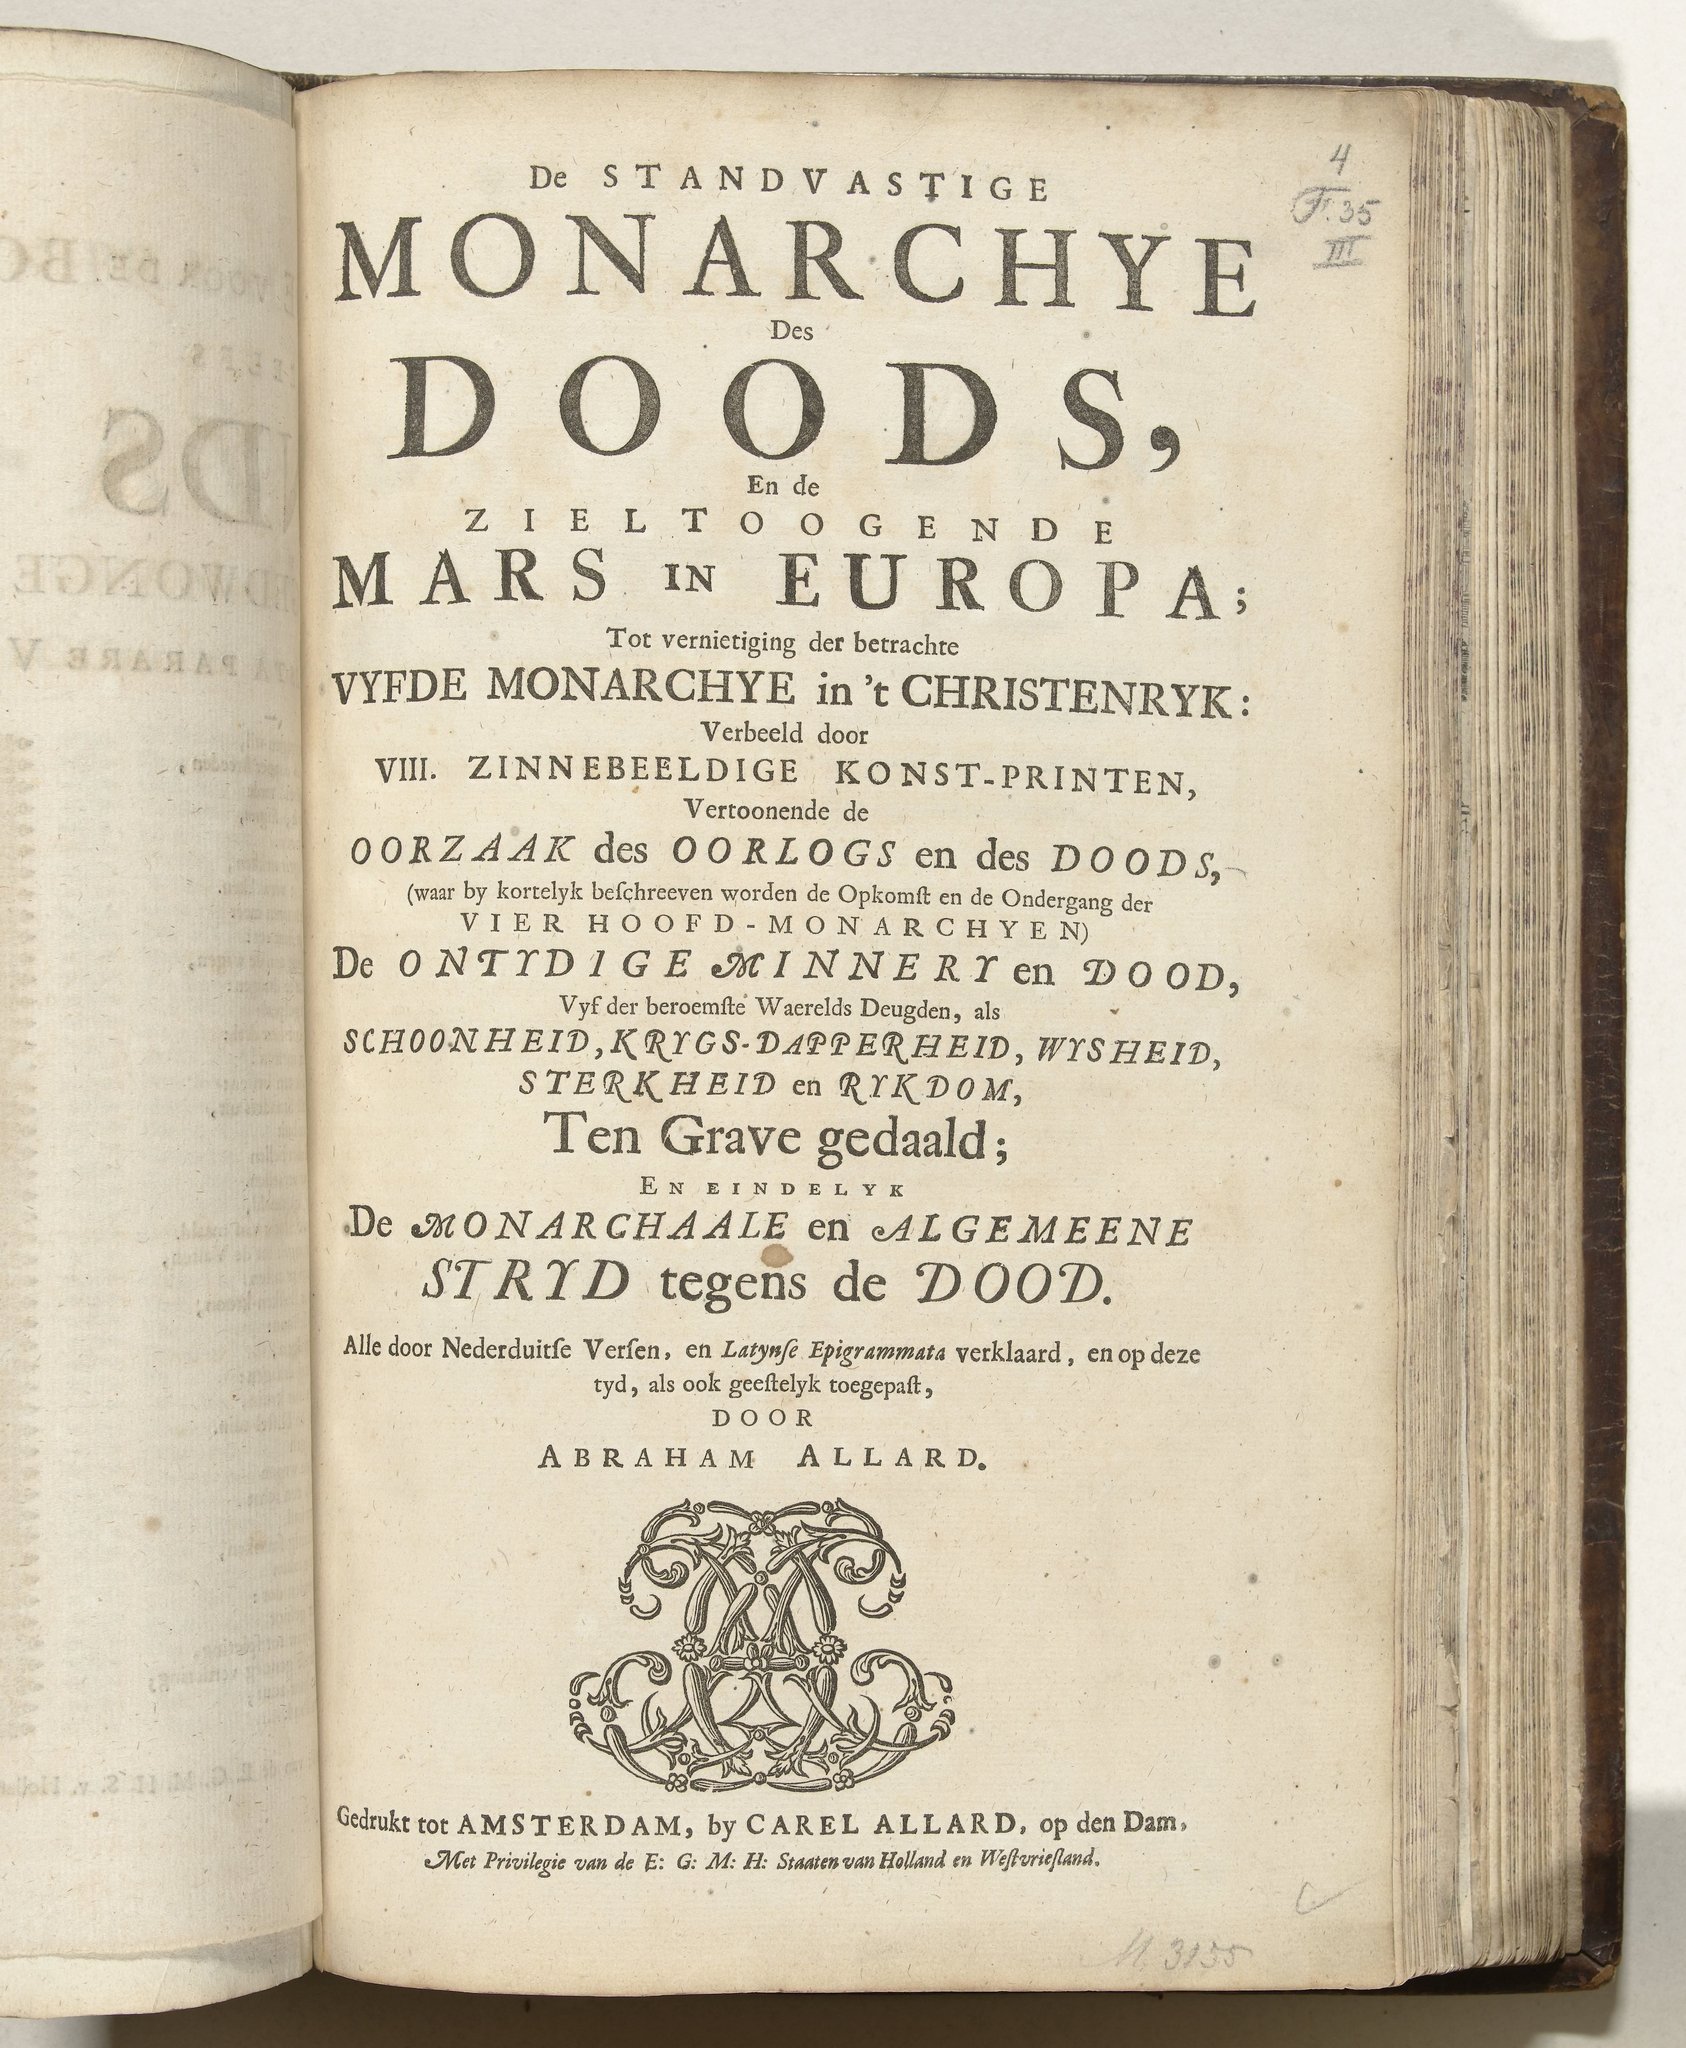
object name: titelblad, titelpagina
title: De Standvastige Monarchye des Doods, En de Zieltoogende Mars in Europa; Tot vernietiging der betrachte Vyfde Monarchye in 't Christenryk: Verbeeld door VIII. Zinnebeeldige Konst-Printen (...)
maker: carel allard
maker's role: print maker, publisher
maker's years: 1648-1709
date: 1707-1708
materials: paper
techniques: letterpress printing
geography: amsterdam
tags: spaanse successieoorlog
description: Titelpagina voor: De Standvastige Monarchye des Doods, ca. 1707-1708, een reeks van 8 oude platen met verzen aangepast voor gebruik als spotprenten op de Fransen in de context van de Spaanse Successieoorlog. Onderdeel van het prentwerk uitgegeven onder de verzameltitel 't Lust-Hof van Momus met de gebundelde series van spotprenten tijdens de jaren 1701-1713 van de Spaanse Successieoorlog.